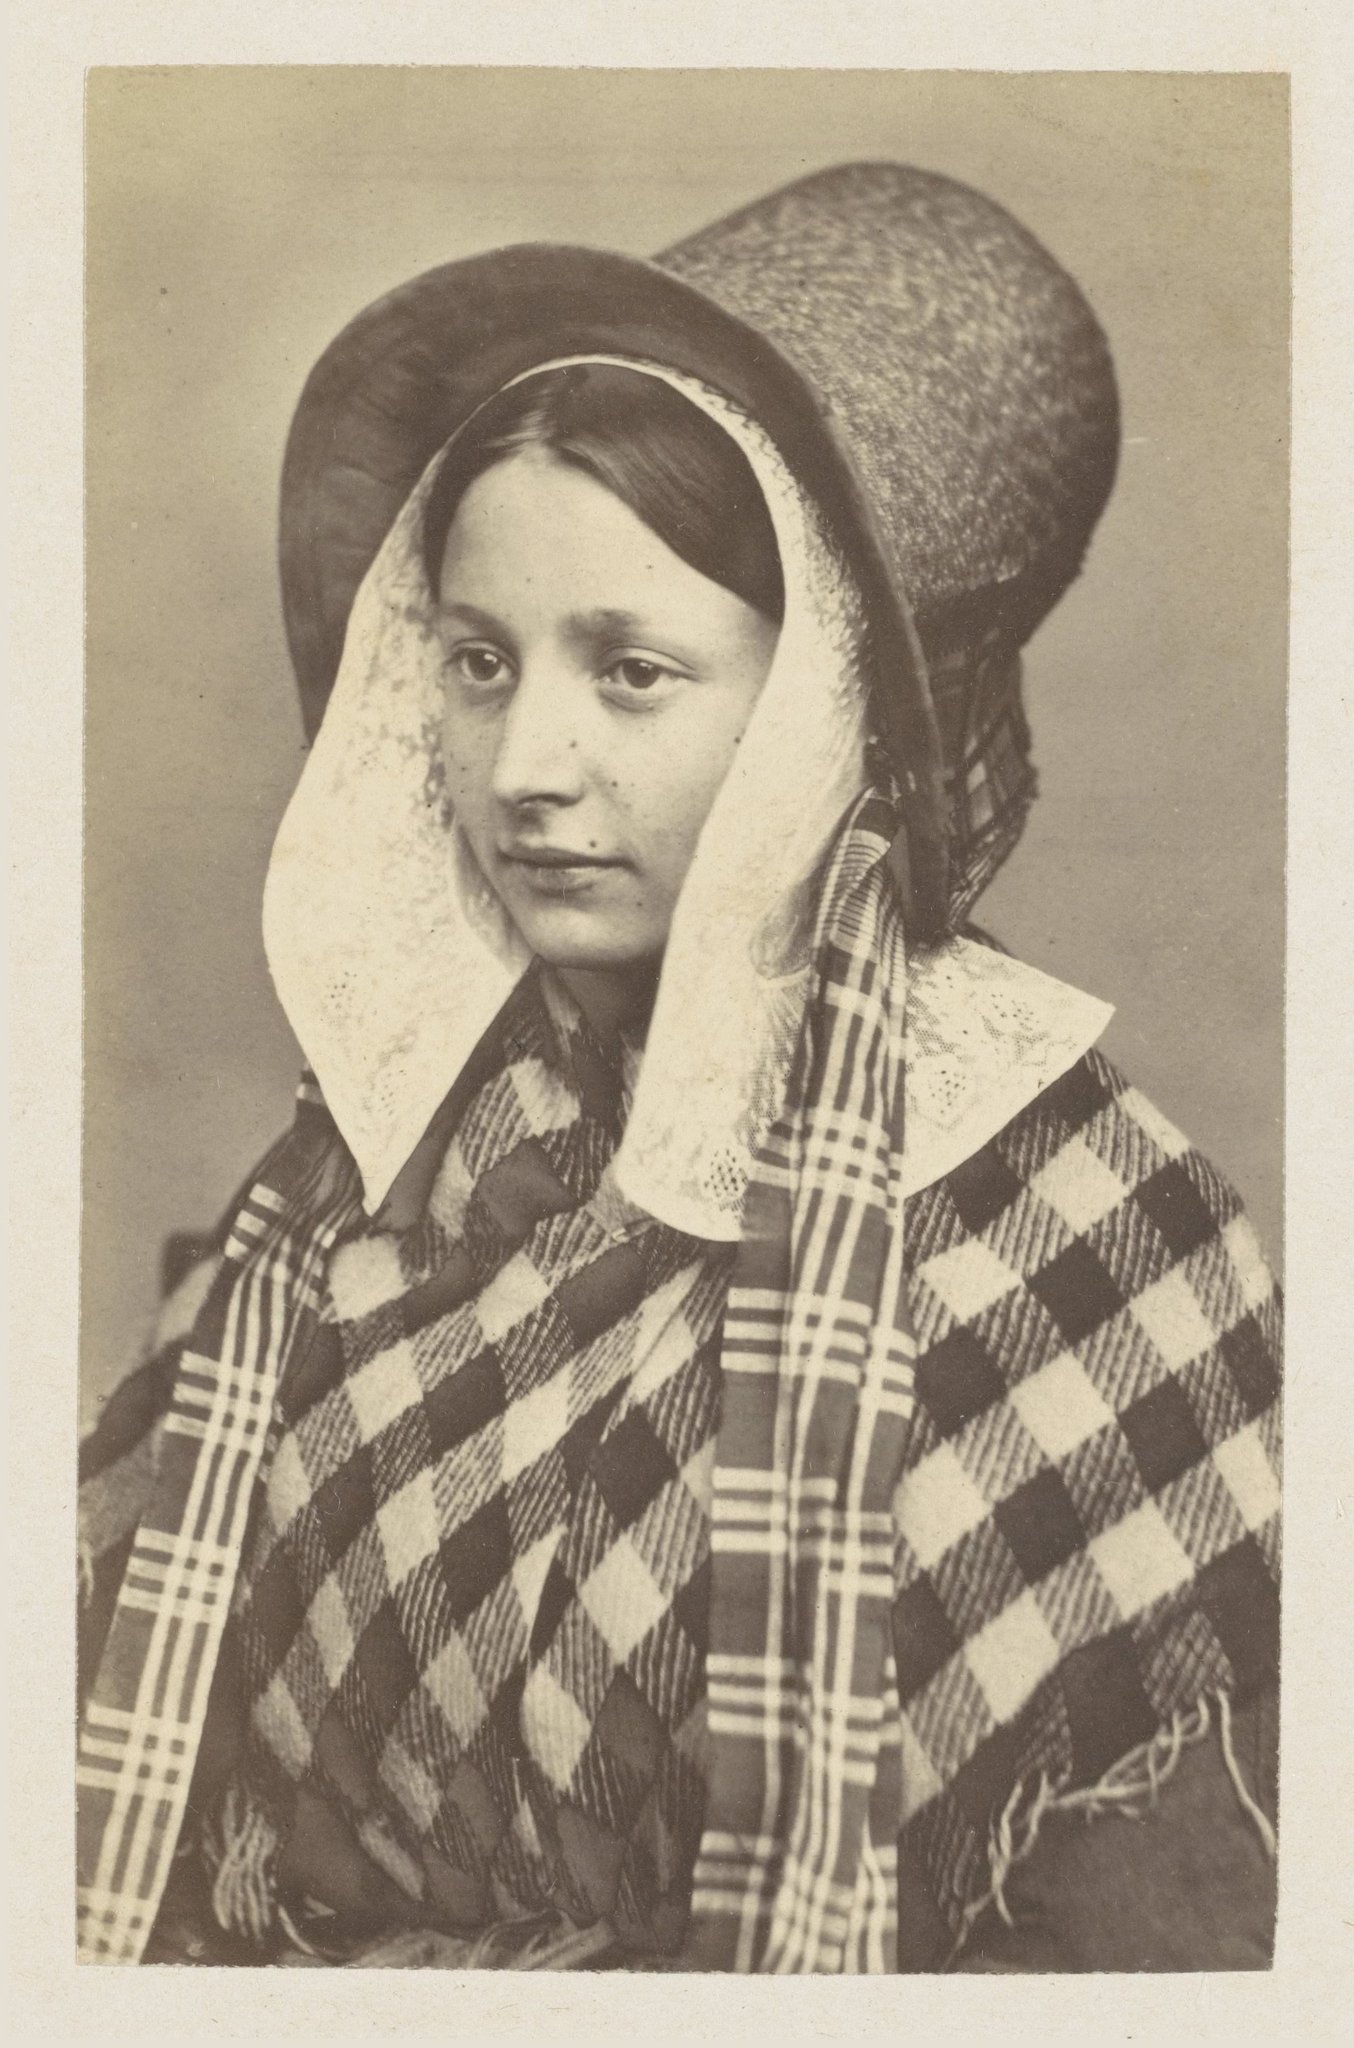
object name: photograph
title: Portret van een onbekende vrouw, mogelijk uit Antwerpen, in traditionele kleding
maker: Anonymous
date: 1860-1900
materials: cardboard, paper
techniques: albumen print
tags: historical persons - bb - woman, folk costume, regional costume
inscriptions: inscription: ‘400 nt’, inscription: ‘Antwerpse Typen/ gekocht Antwerpen april 1976 Bfr 400’